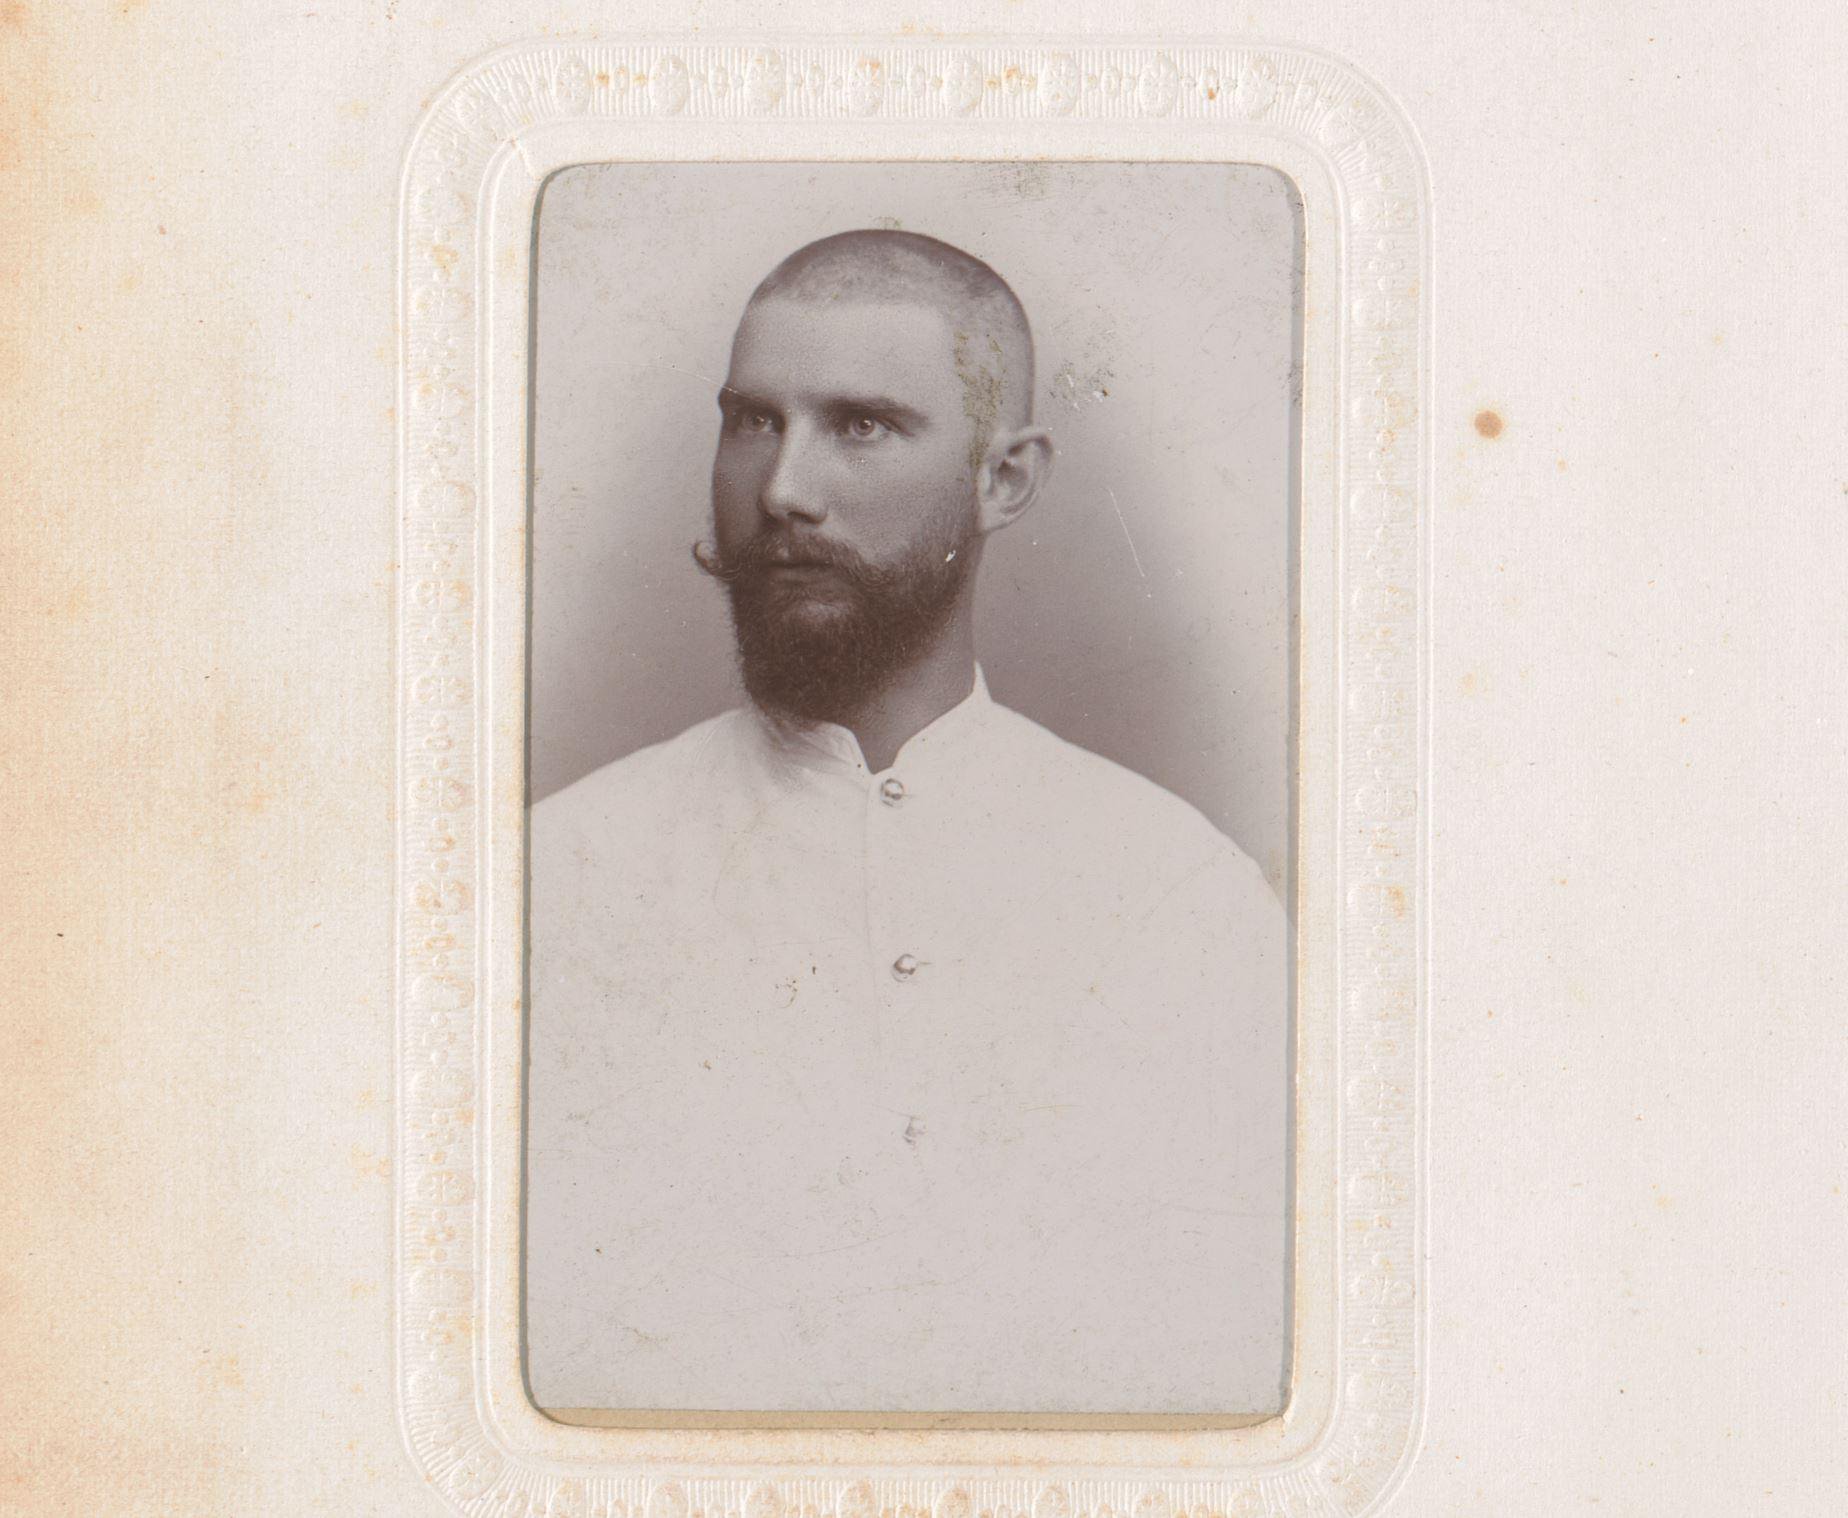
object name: album leaf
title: Portret van een man met snor en baard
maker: Anonymous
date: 1880-1920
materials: cardboard, photographic support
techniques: collodion silver print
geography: netherlands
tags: moustache, historical persons, beard